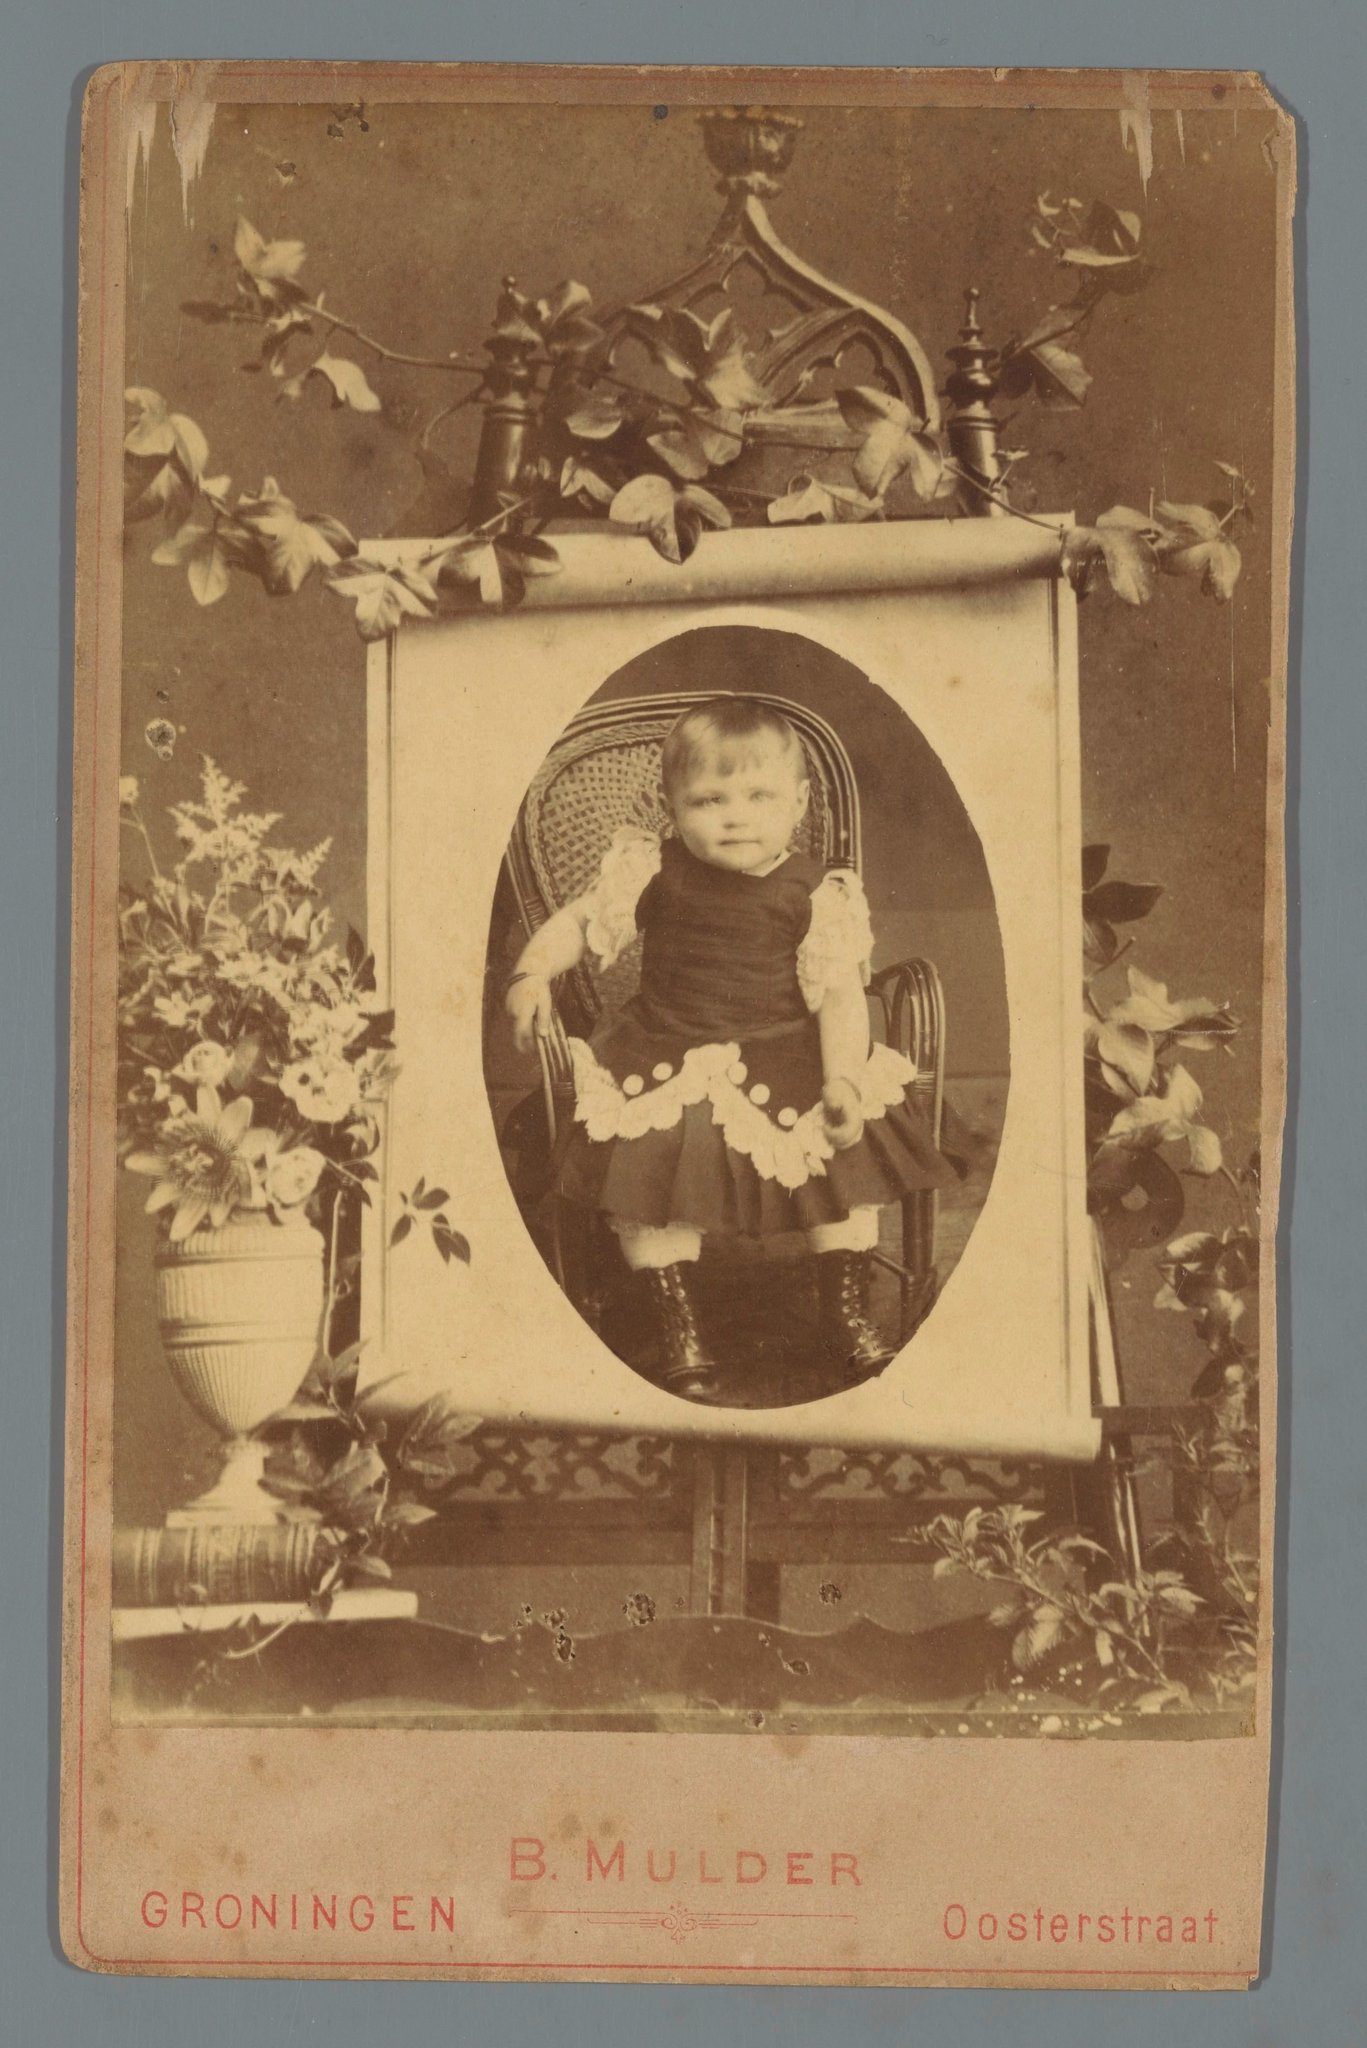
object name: photograph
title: Portret van een klein kind op een stoel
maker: berend mulder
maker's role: fotograaf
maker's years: 1854-1926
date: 1880-1900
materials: cardboard, photographic support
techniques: albumen print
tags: child (at home)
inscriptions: : ‘Het negatief blyft ter nabestelling bewaard’, : ‘Photographie Instantanée / B. Mulder / Photograaf en Kunstschilder / Vergrooting in alle afmeting naar elk portret / Groningen, Oosterstraat E 211a’, : ‘Groningen, Oosterstraat’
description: Foto is geplaatst op standaard met bloemen, mogelijk ter nagedachtenis aan het kind.